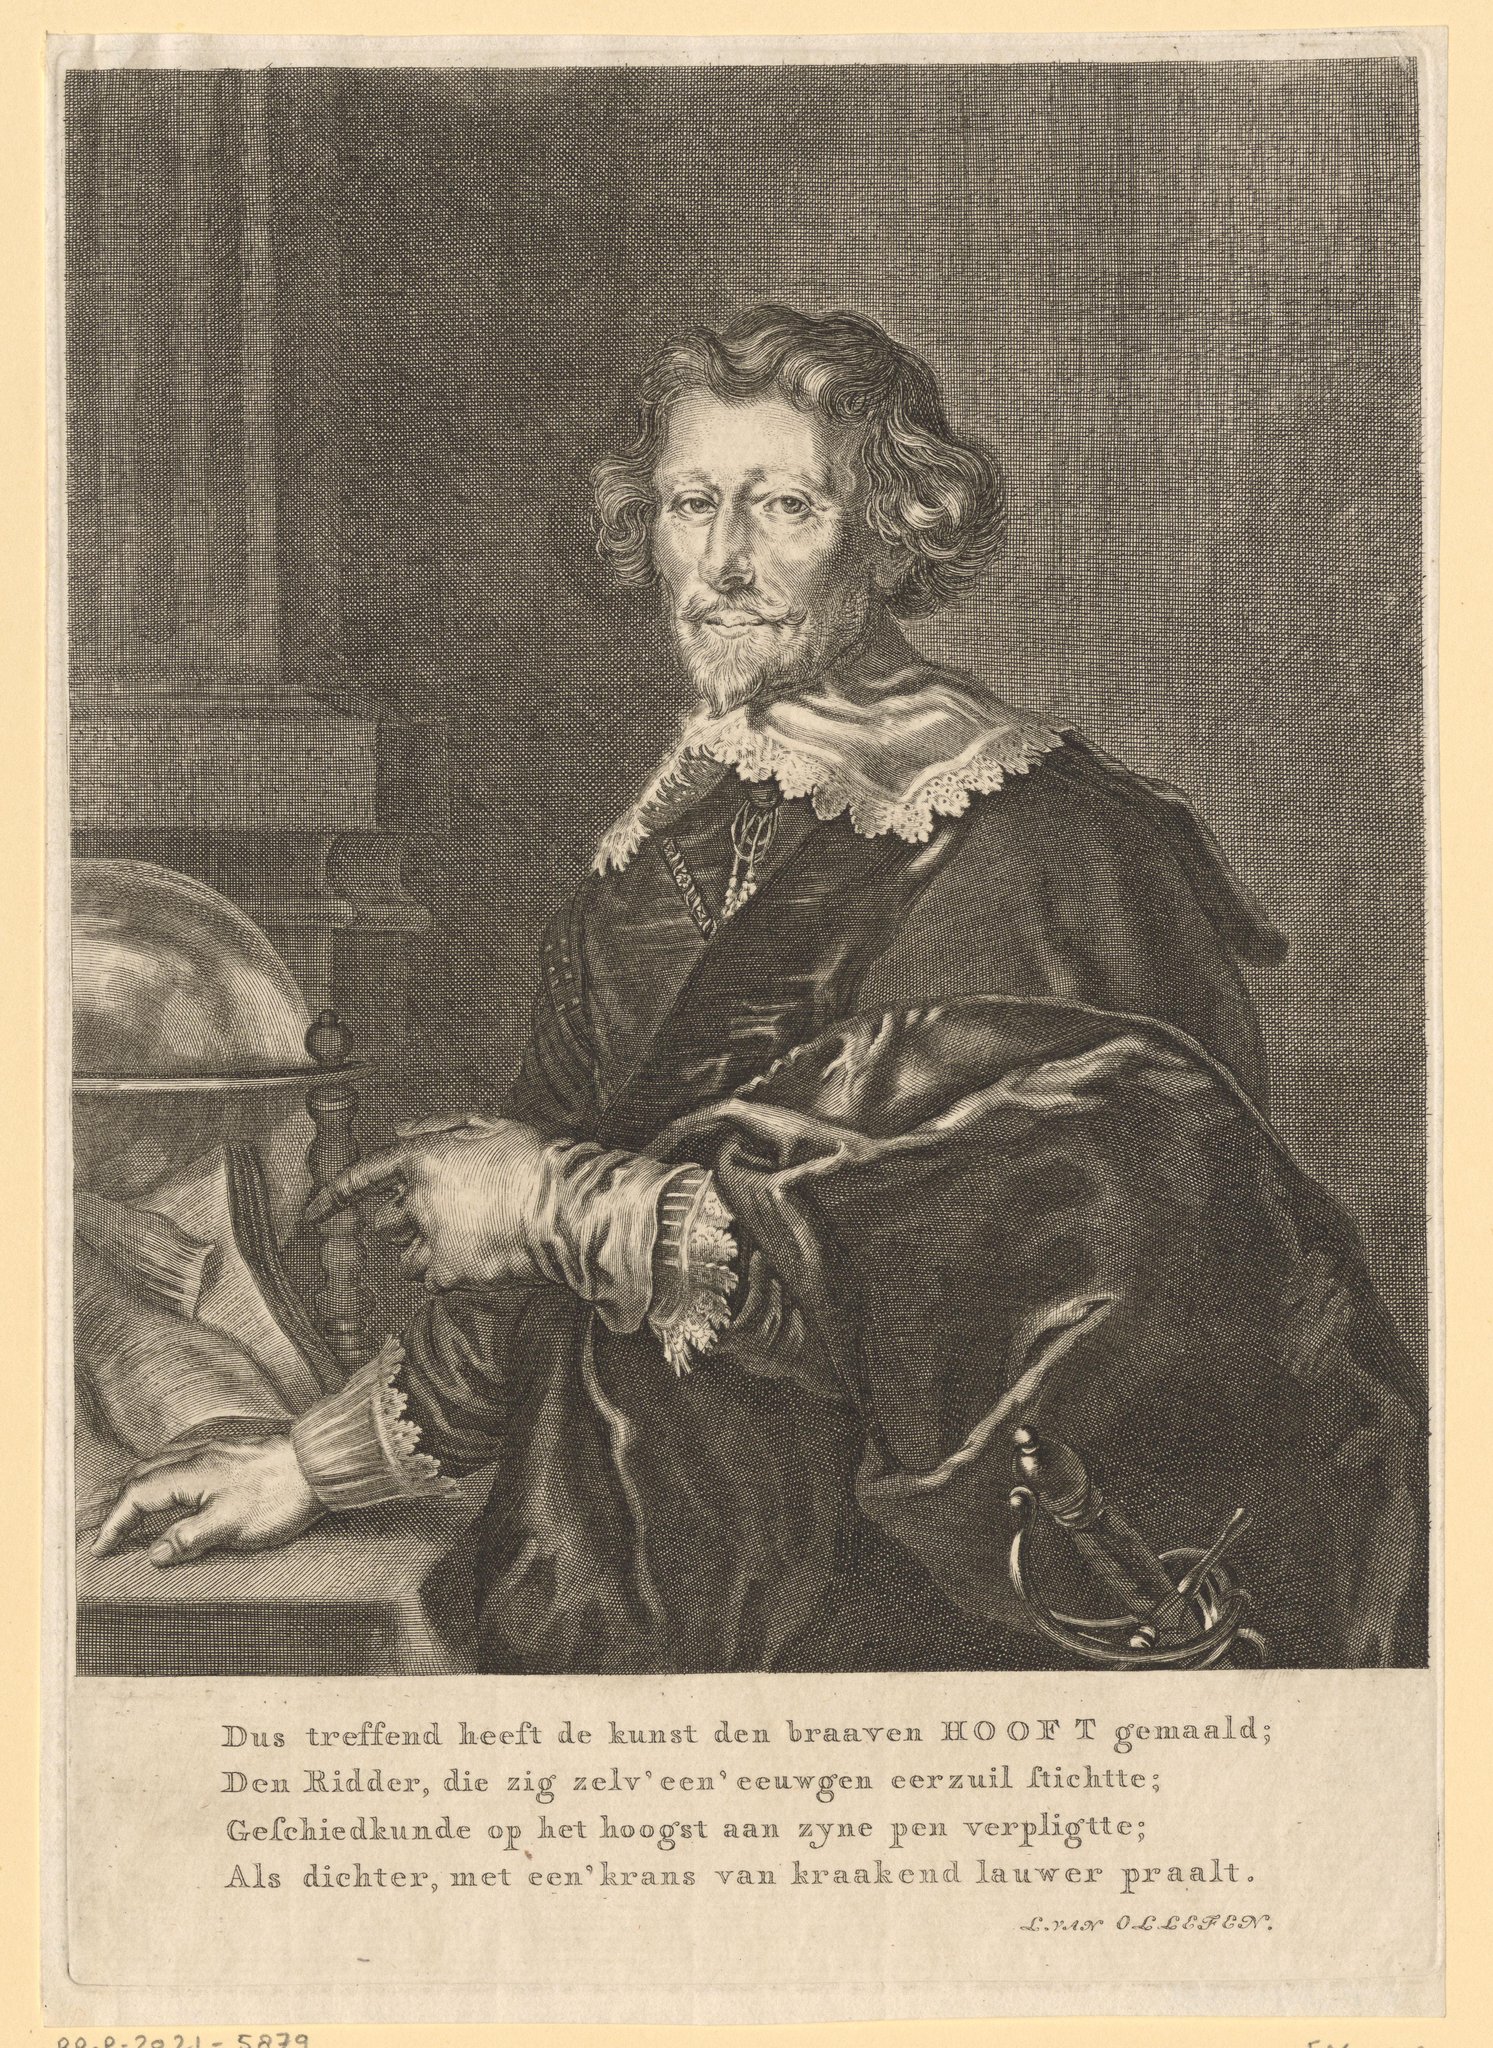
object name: print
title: Portret van Pieter Corneliszoon Hooft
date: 1759-1799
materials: paper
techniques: engraving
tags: amsterdam, the hague, pieter corneliszoon hooft, historical persons, book, writer, poet, author, globe